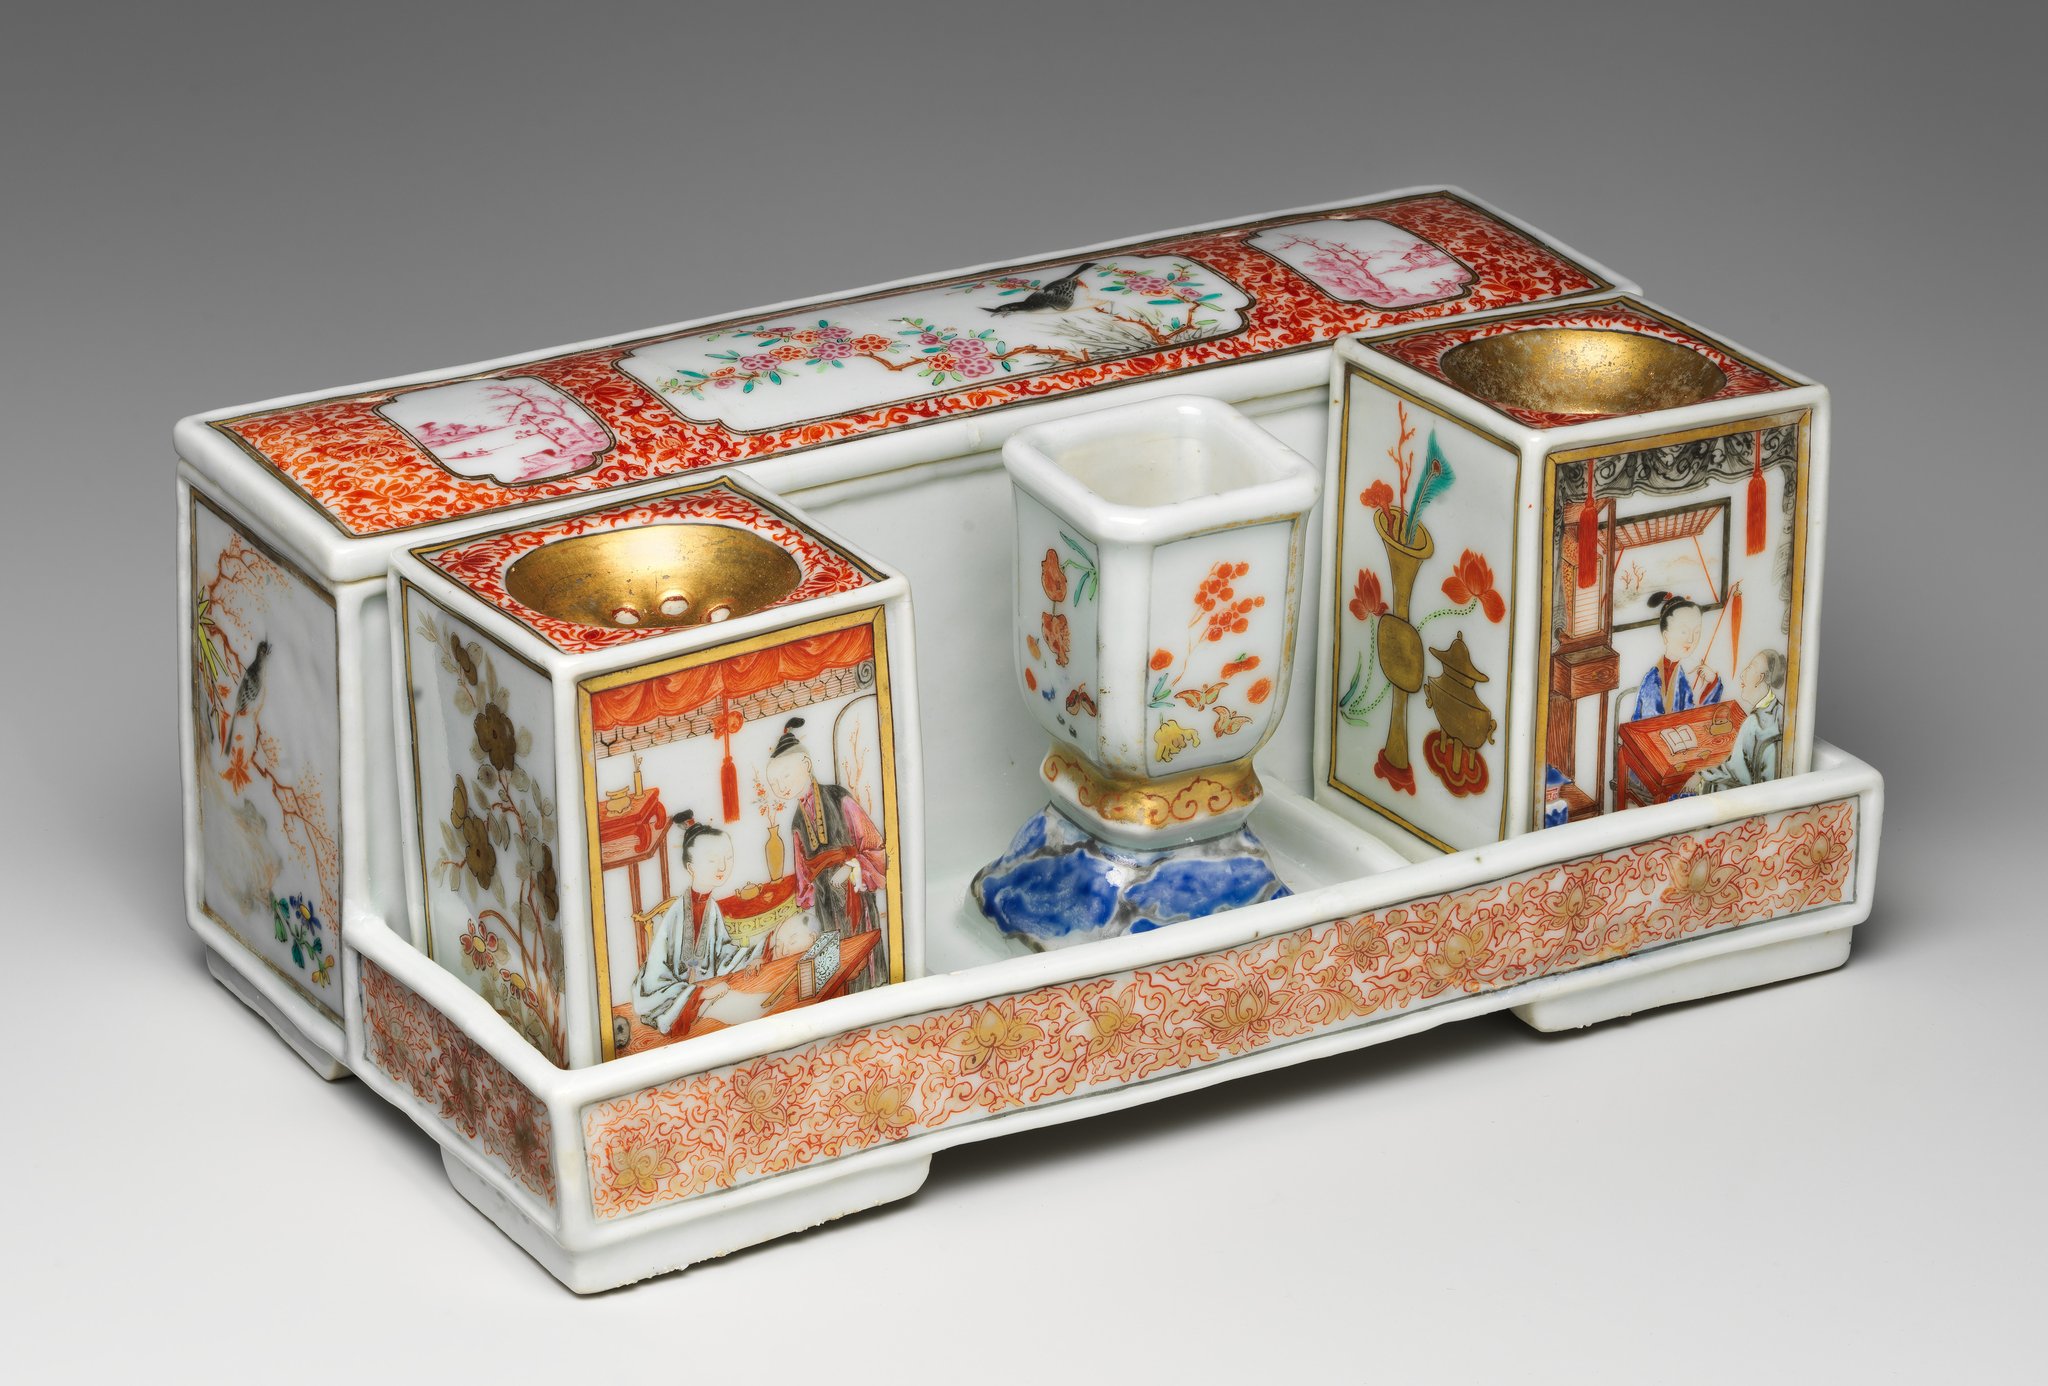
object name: inkstand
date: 1750-1770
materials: hard paste porcelain